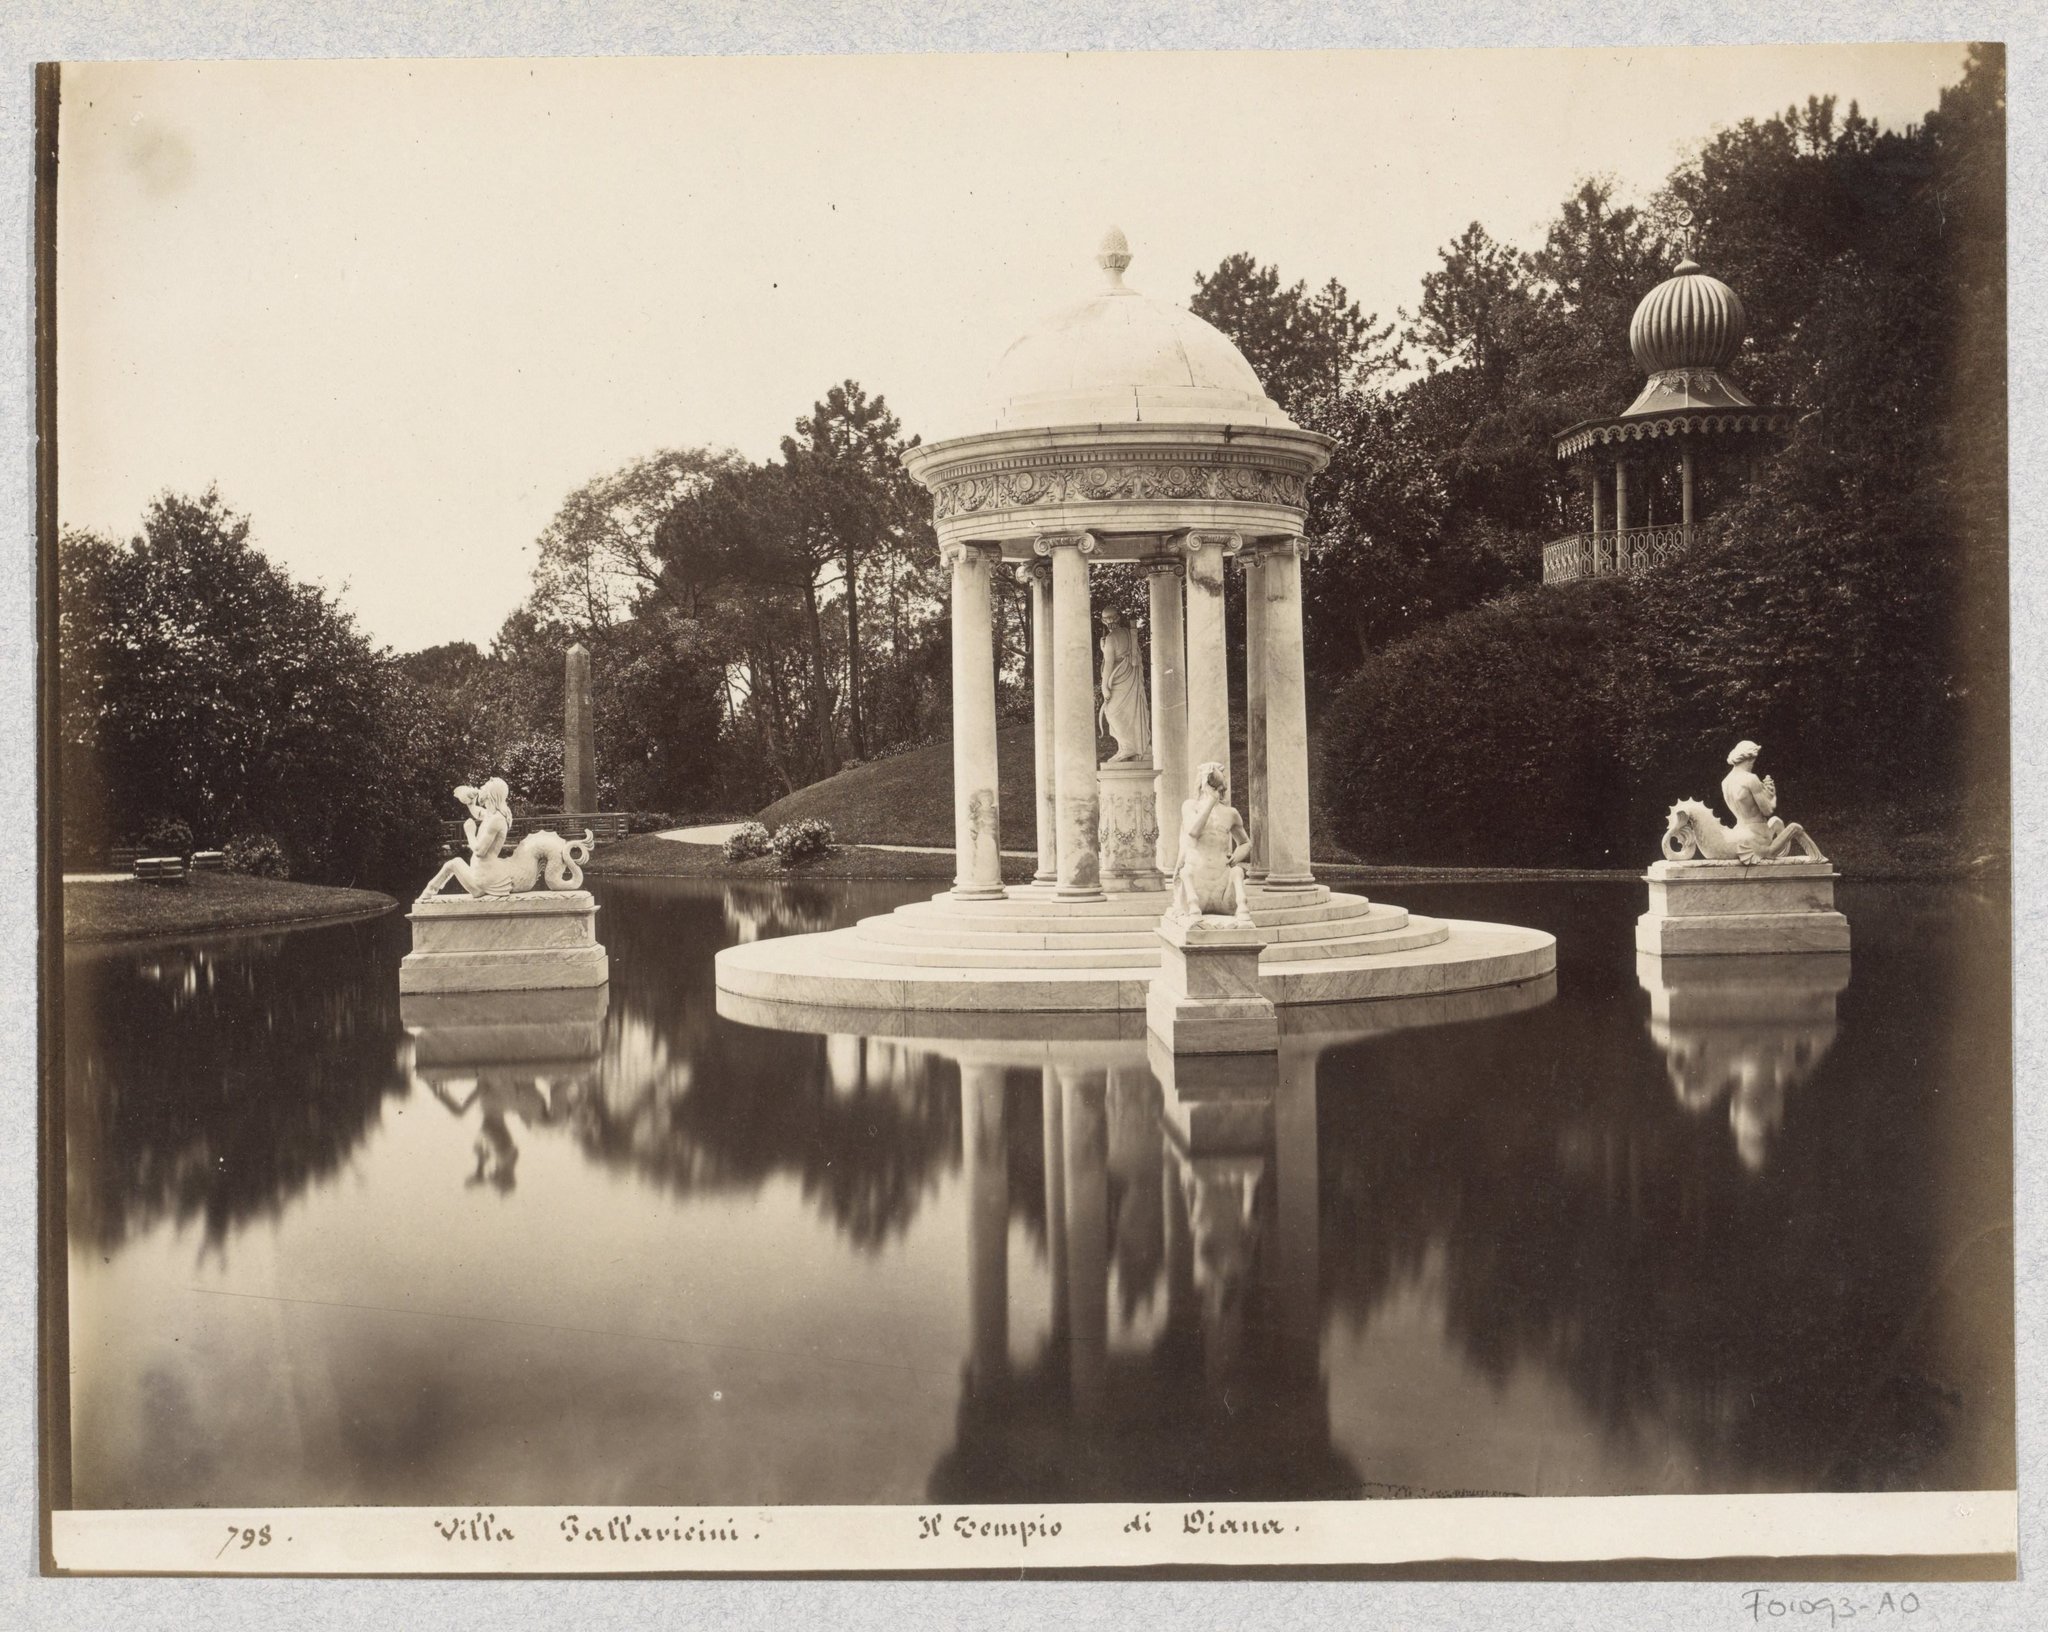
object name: photograph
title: Villa Pallavicini. Il tempio di Diana.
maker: celestino degoix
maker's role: fotograaf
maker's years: 1825-1902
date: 1870-1890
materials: paper, photographic support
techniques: albumen print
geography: pegli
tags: monument, statue, temple, shrine ~ roman religion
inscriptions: negative number: ‘798’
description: Onderdeel van Reisalbum met foto's van bezienswaardigheden in Genua, Florence en Venetië.